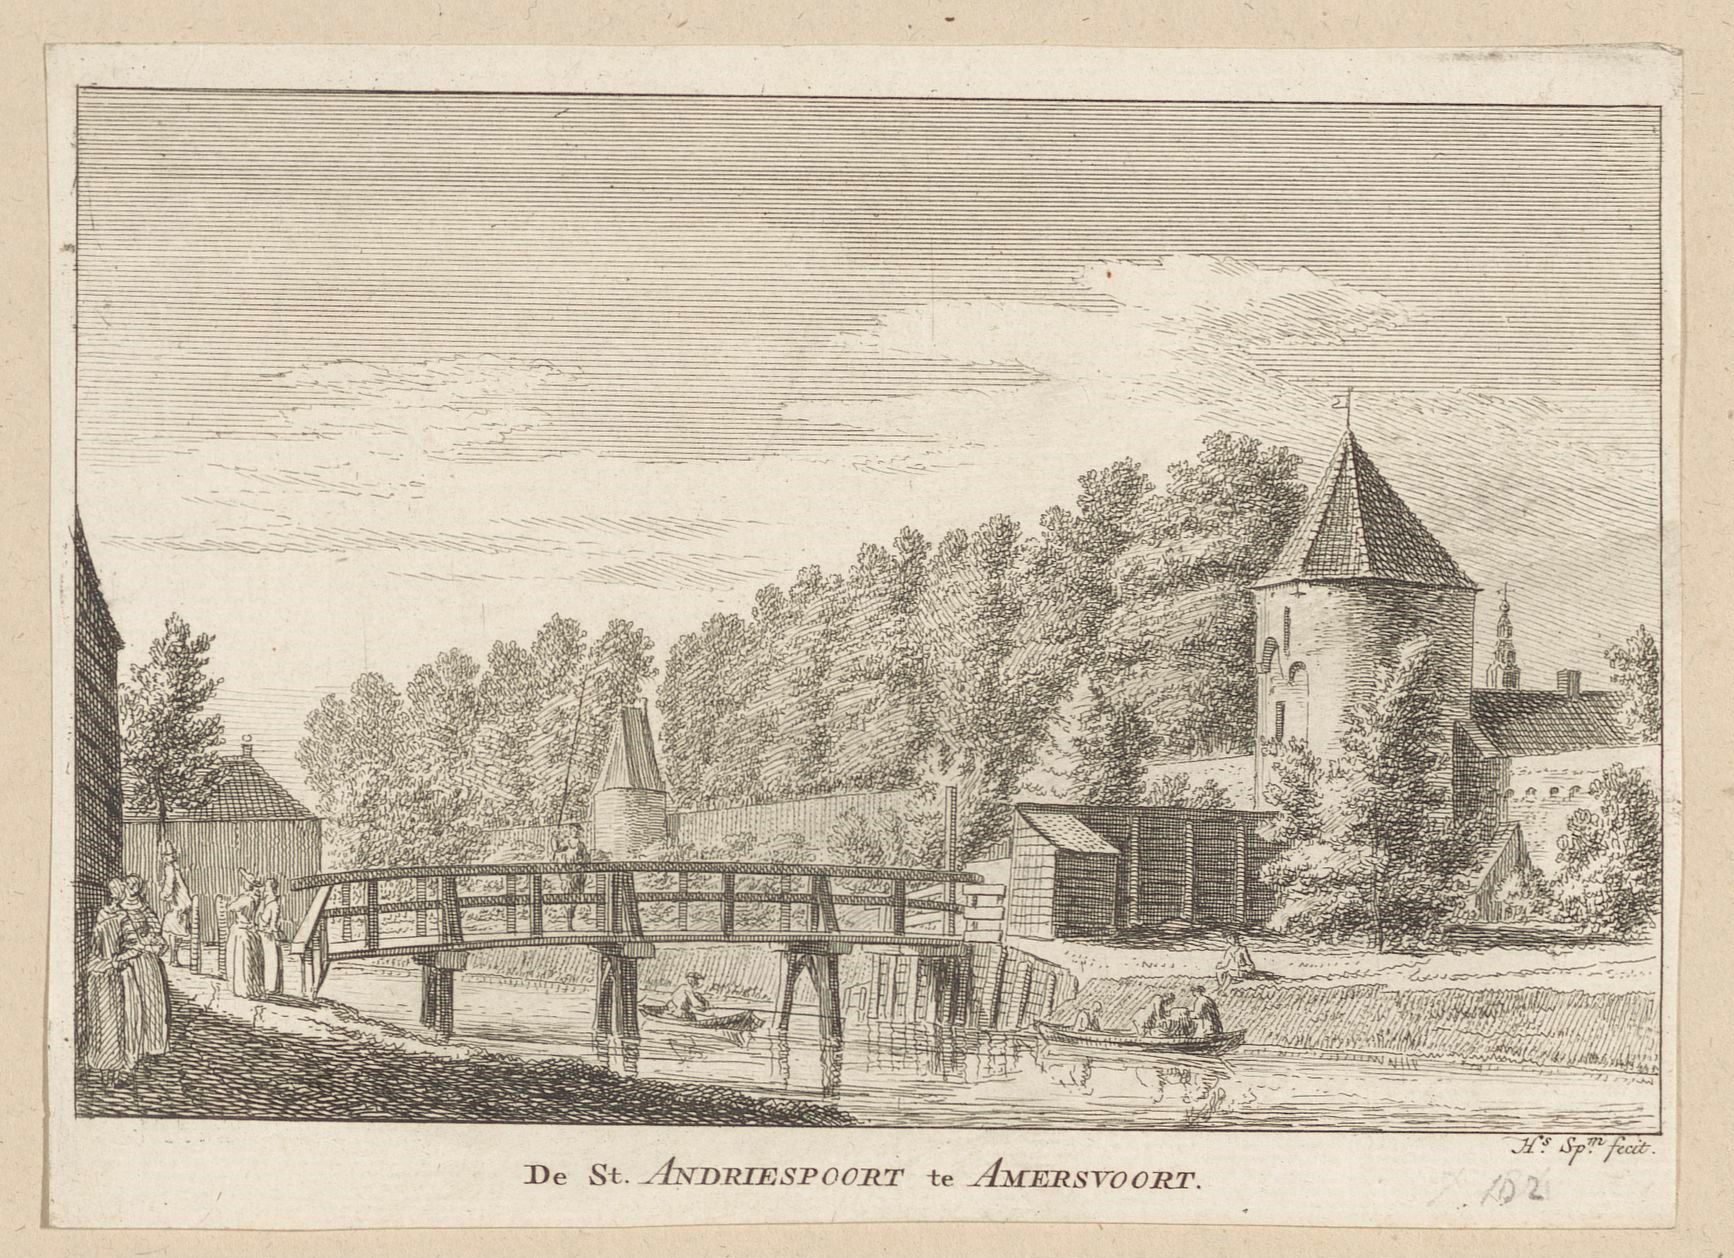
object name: print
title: Gezicht op de Sint Andriespoort te Amersfoort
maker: hendrik spilman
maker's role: draughtsman, painter, print maker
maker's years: 1721-1784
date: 1742-1784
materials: paper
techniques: engraving, etching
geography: haarlem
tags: bridge, city-gate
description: Gezicht op de Sint Andriespoort te Amersfoort met een brug over de singel.